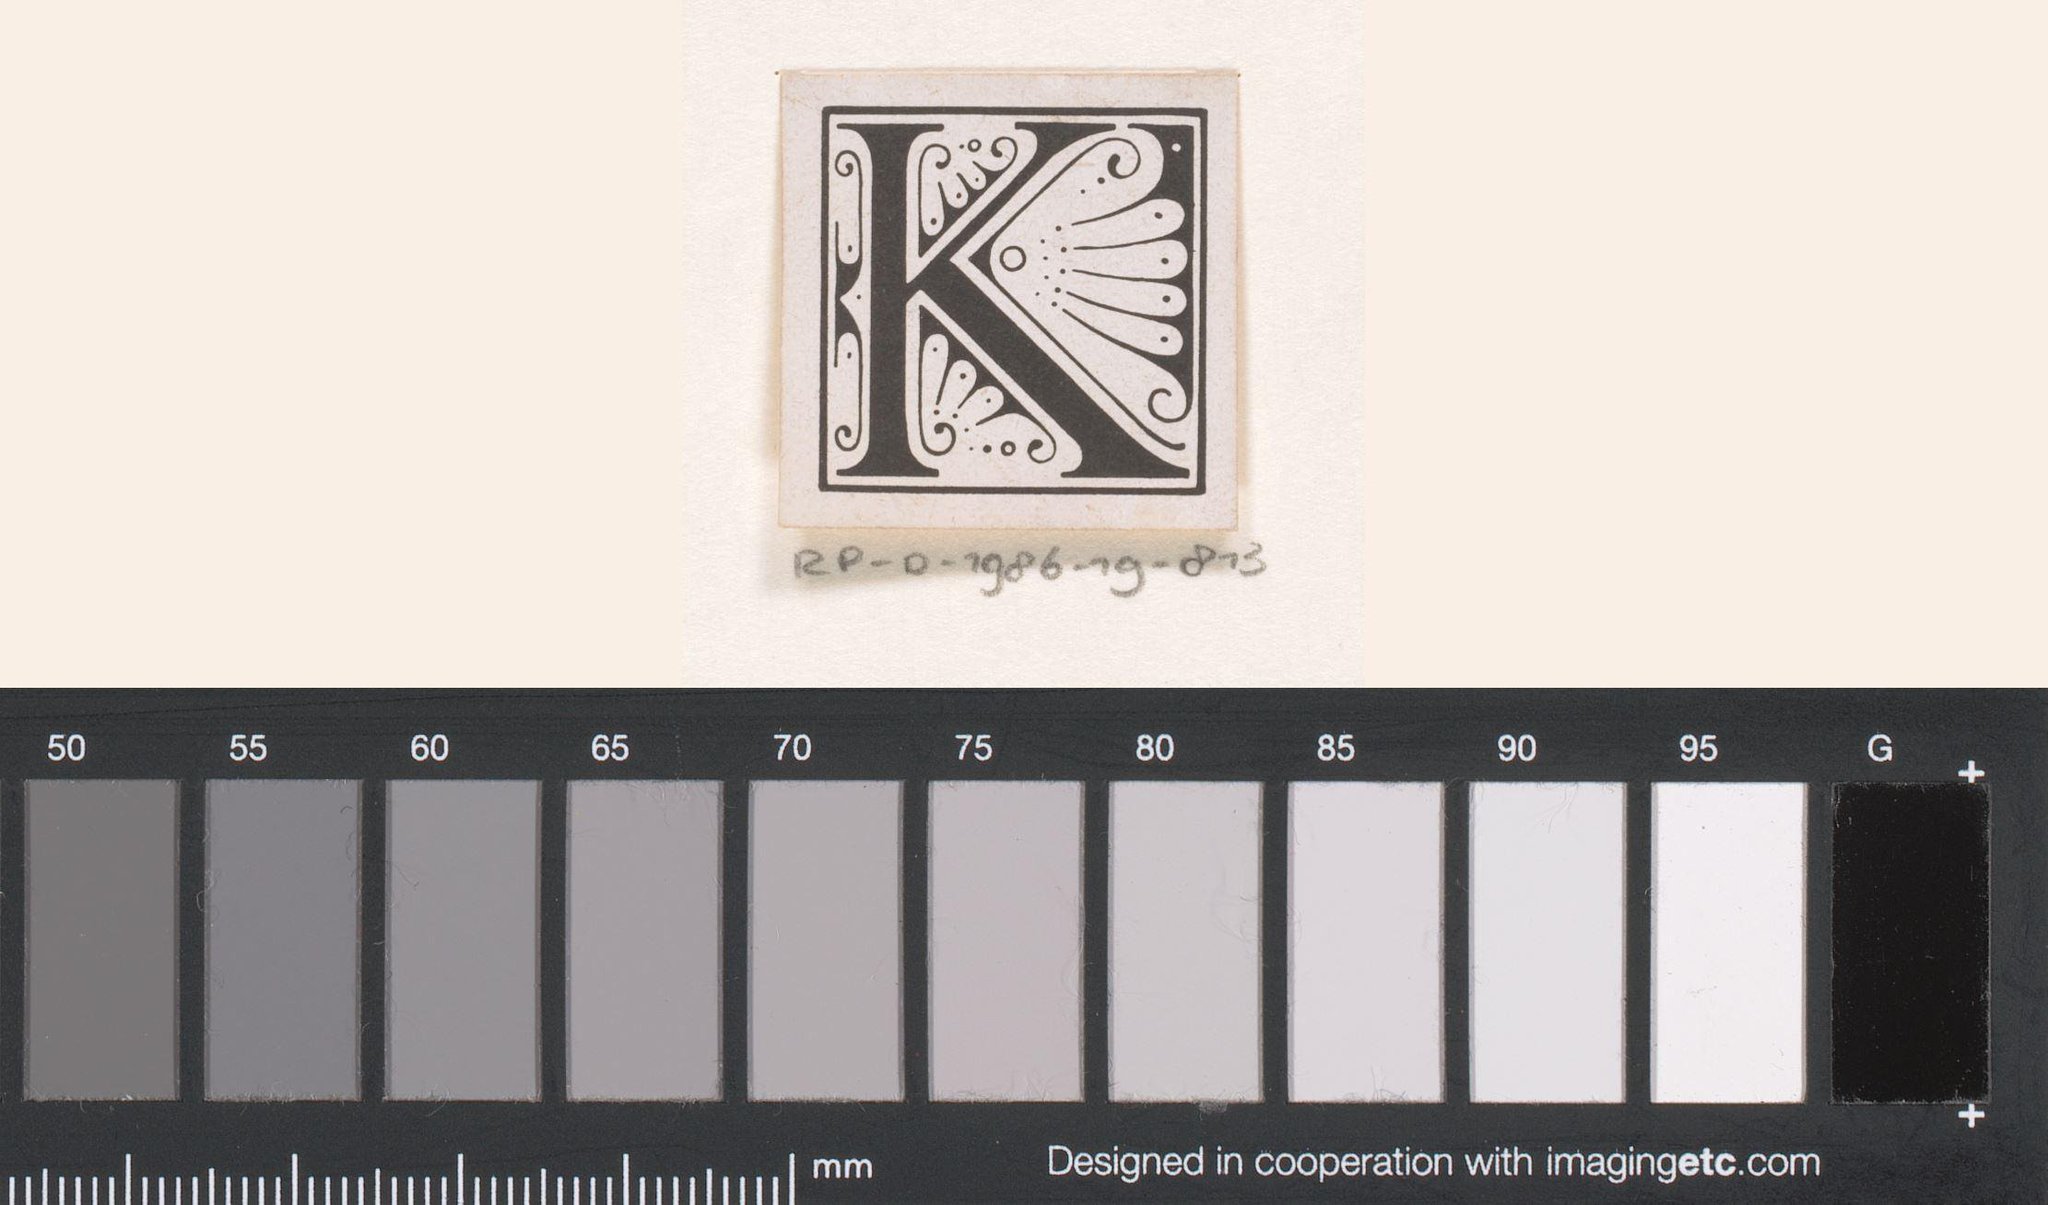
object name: photomechanical print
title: Initiaal K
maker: reinier willem petrus de vries (1874-1953)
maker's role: draughtsman, print maker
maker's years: 1874-1953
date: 1904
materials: paper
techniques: printing block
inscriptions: collector's mark: ‘R:MVS.’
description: Het initiaal is gebruikt voor: Veth, Jan. Jozef Israëls en zijn kunst. Arnhem en Nijmegen: Gebroeders E&M Cohen, 1904.